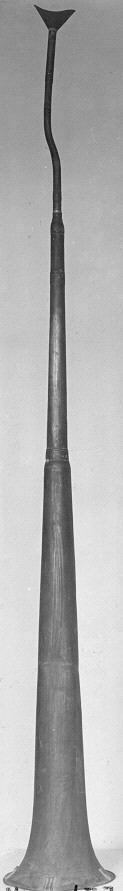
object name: trumpet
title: Speaking Trumpet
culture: european or american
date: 1701-1800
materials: metal